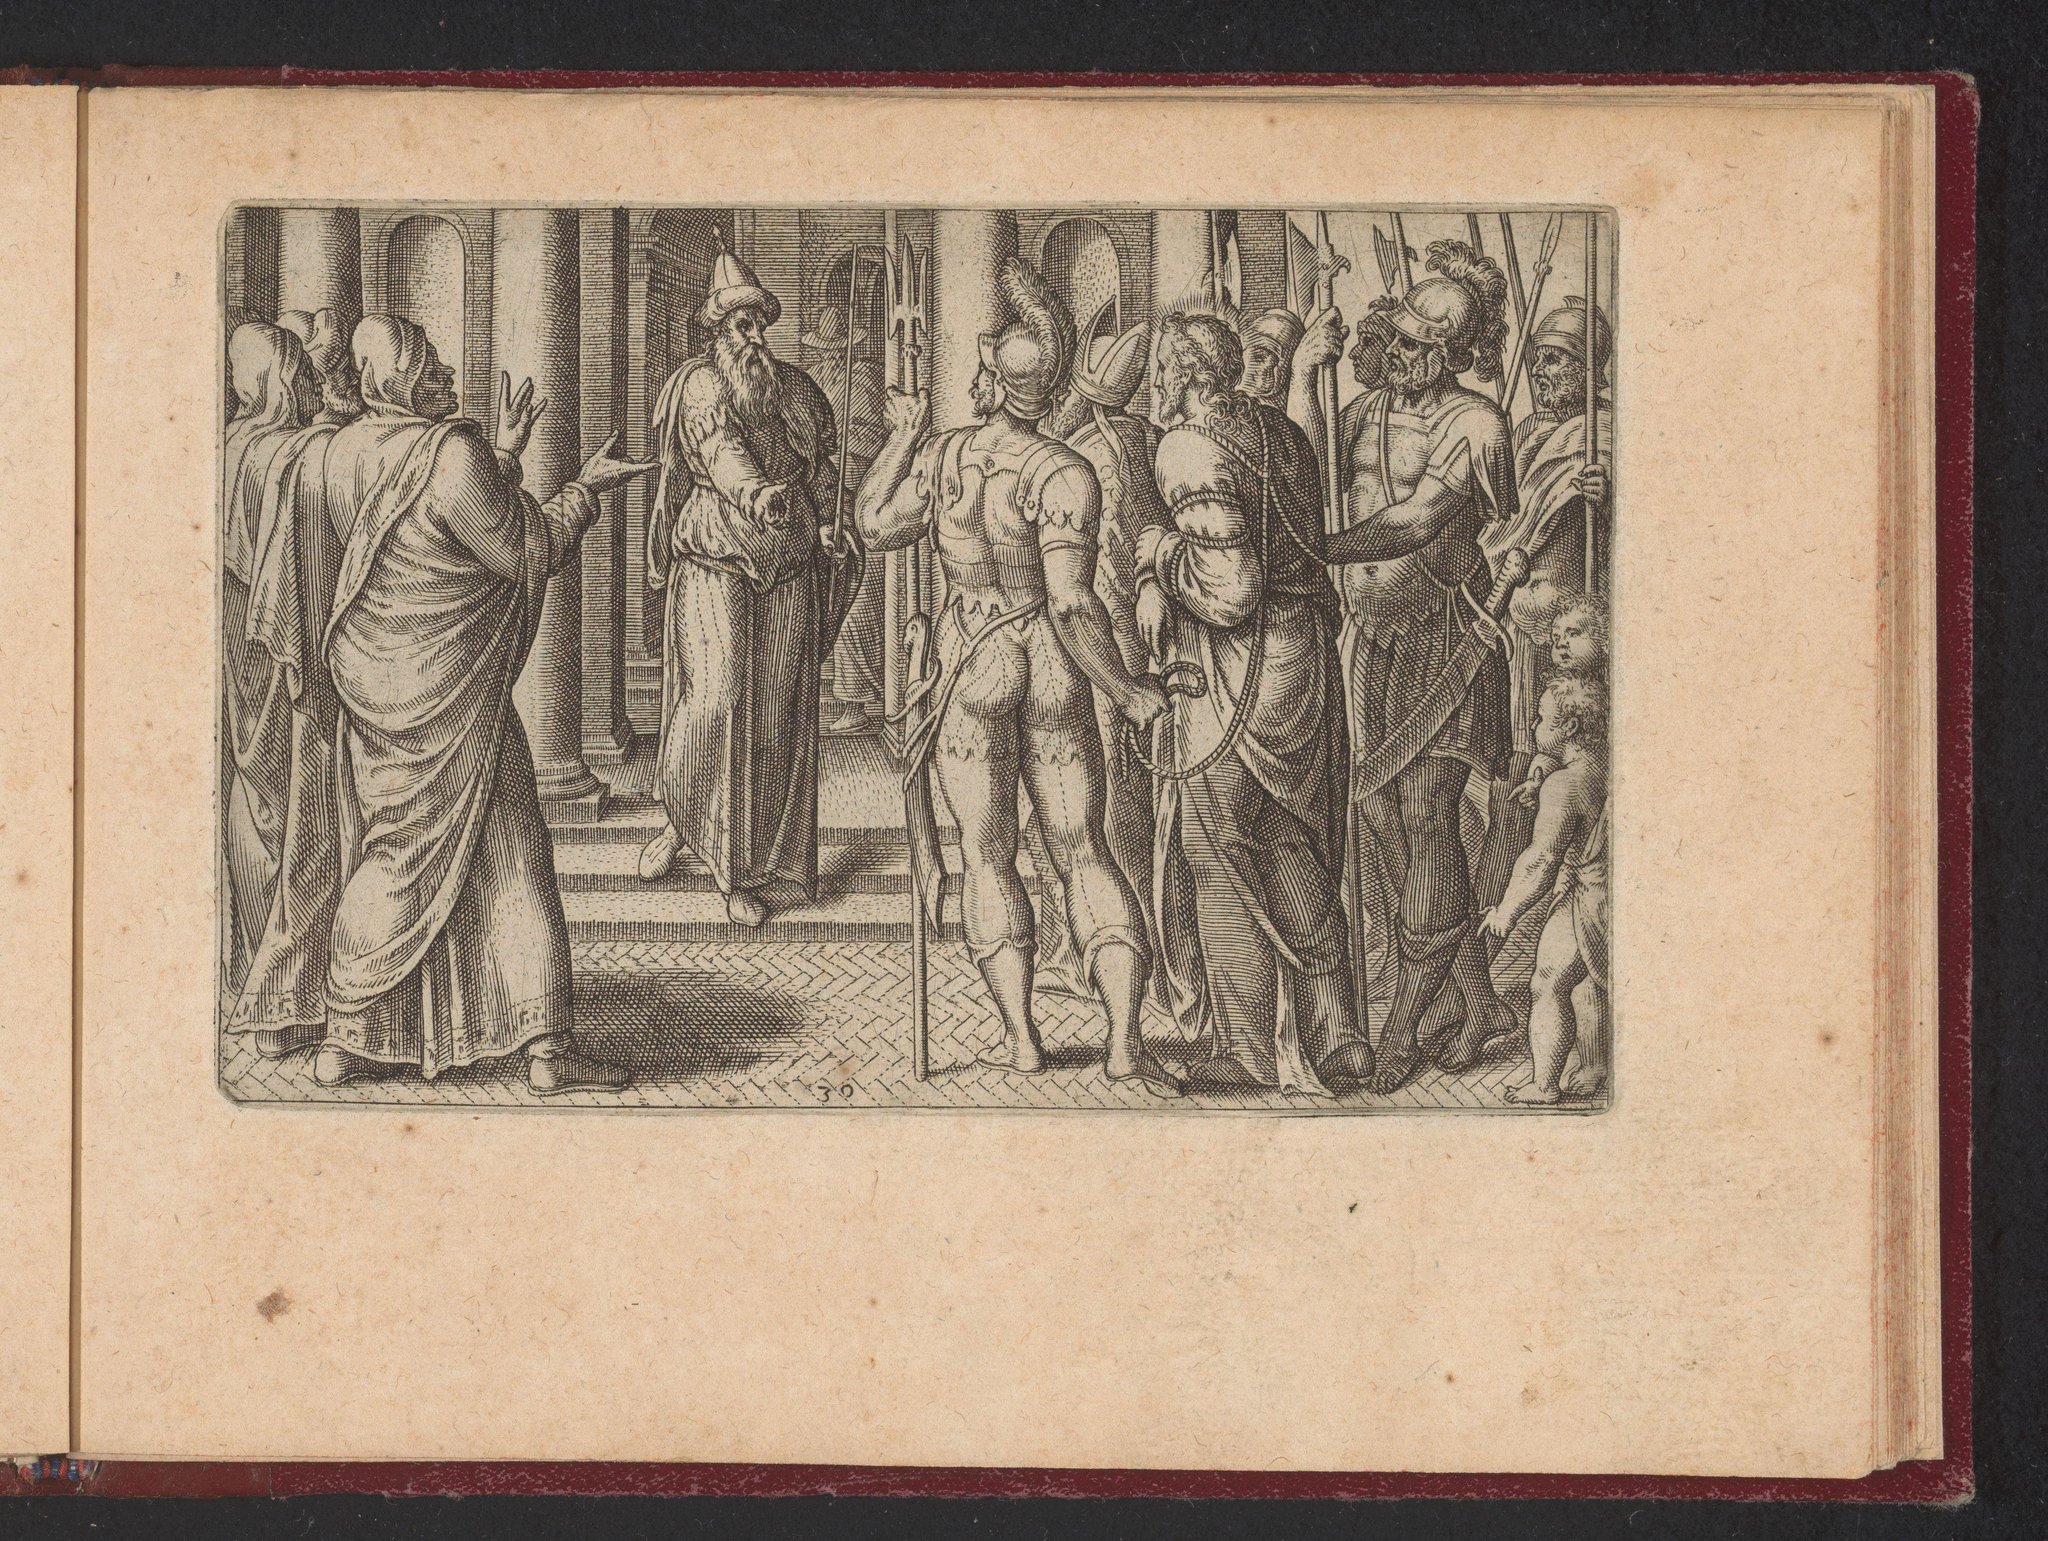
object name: print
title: Christi Iesu vitae admirabiliumque actionum speculum a Philippo Gallaeo apparatum Bened. Ariae Montani singuloribus distichis instructum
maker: philips galle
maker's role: print maker, publisher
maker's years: 1537-1612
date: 1573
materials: paper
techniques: engraving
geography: antwerp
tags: christ before pontius pilate (matthew 27:11-26; mark 15:2-15; luke 23:2-7, 23:13-25; john 18:28 - 19:16)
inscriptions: watermark: ‘gotische letter P’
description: Onderdeel van een album met een titelprent en een serie van 50 prenten betreffende het leven en de passie van Christus.